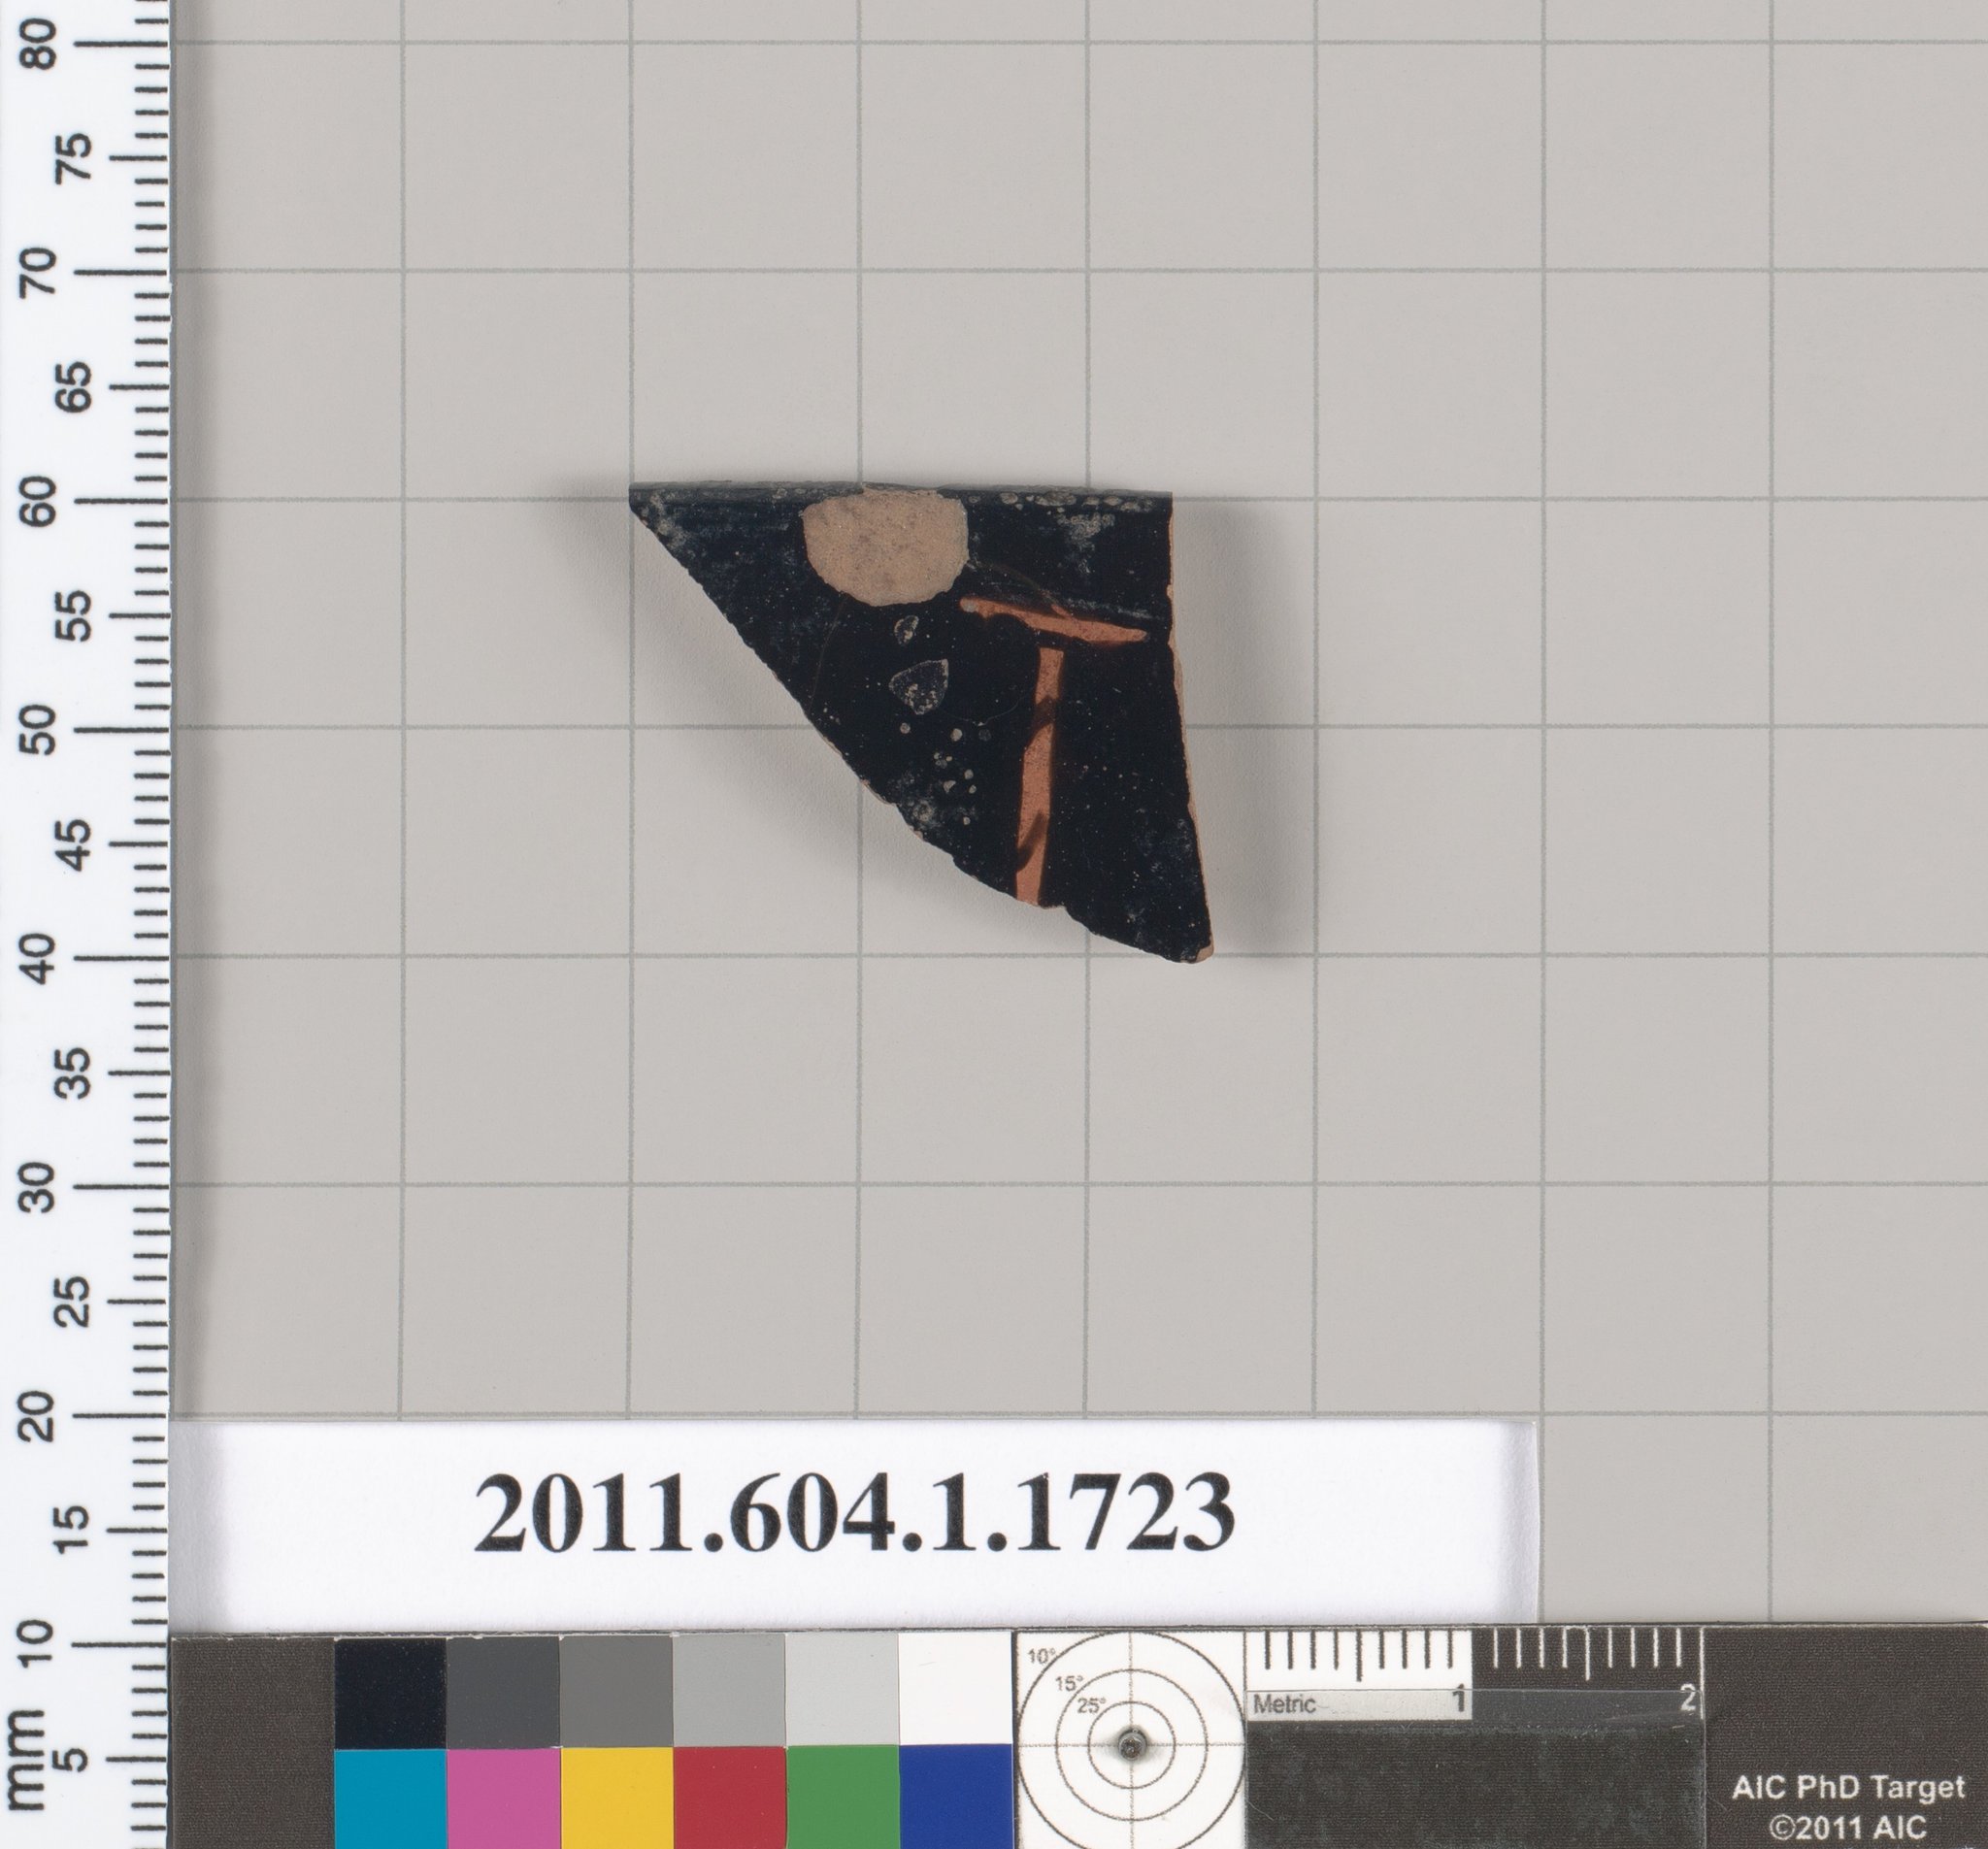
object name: kylix fragment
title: Terracotta rim fragment of a kylix (drinking cup)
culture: greek, attic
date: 475-451 BCE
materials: terracotta